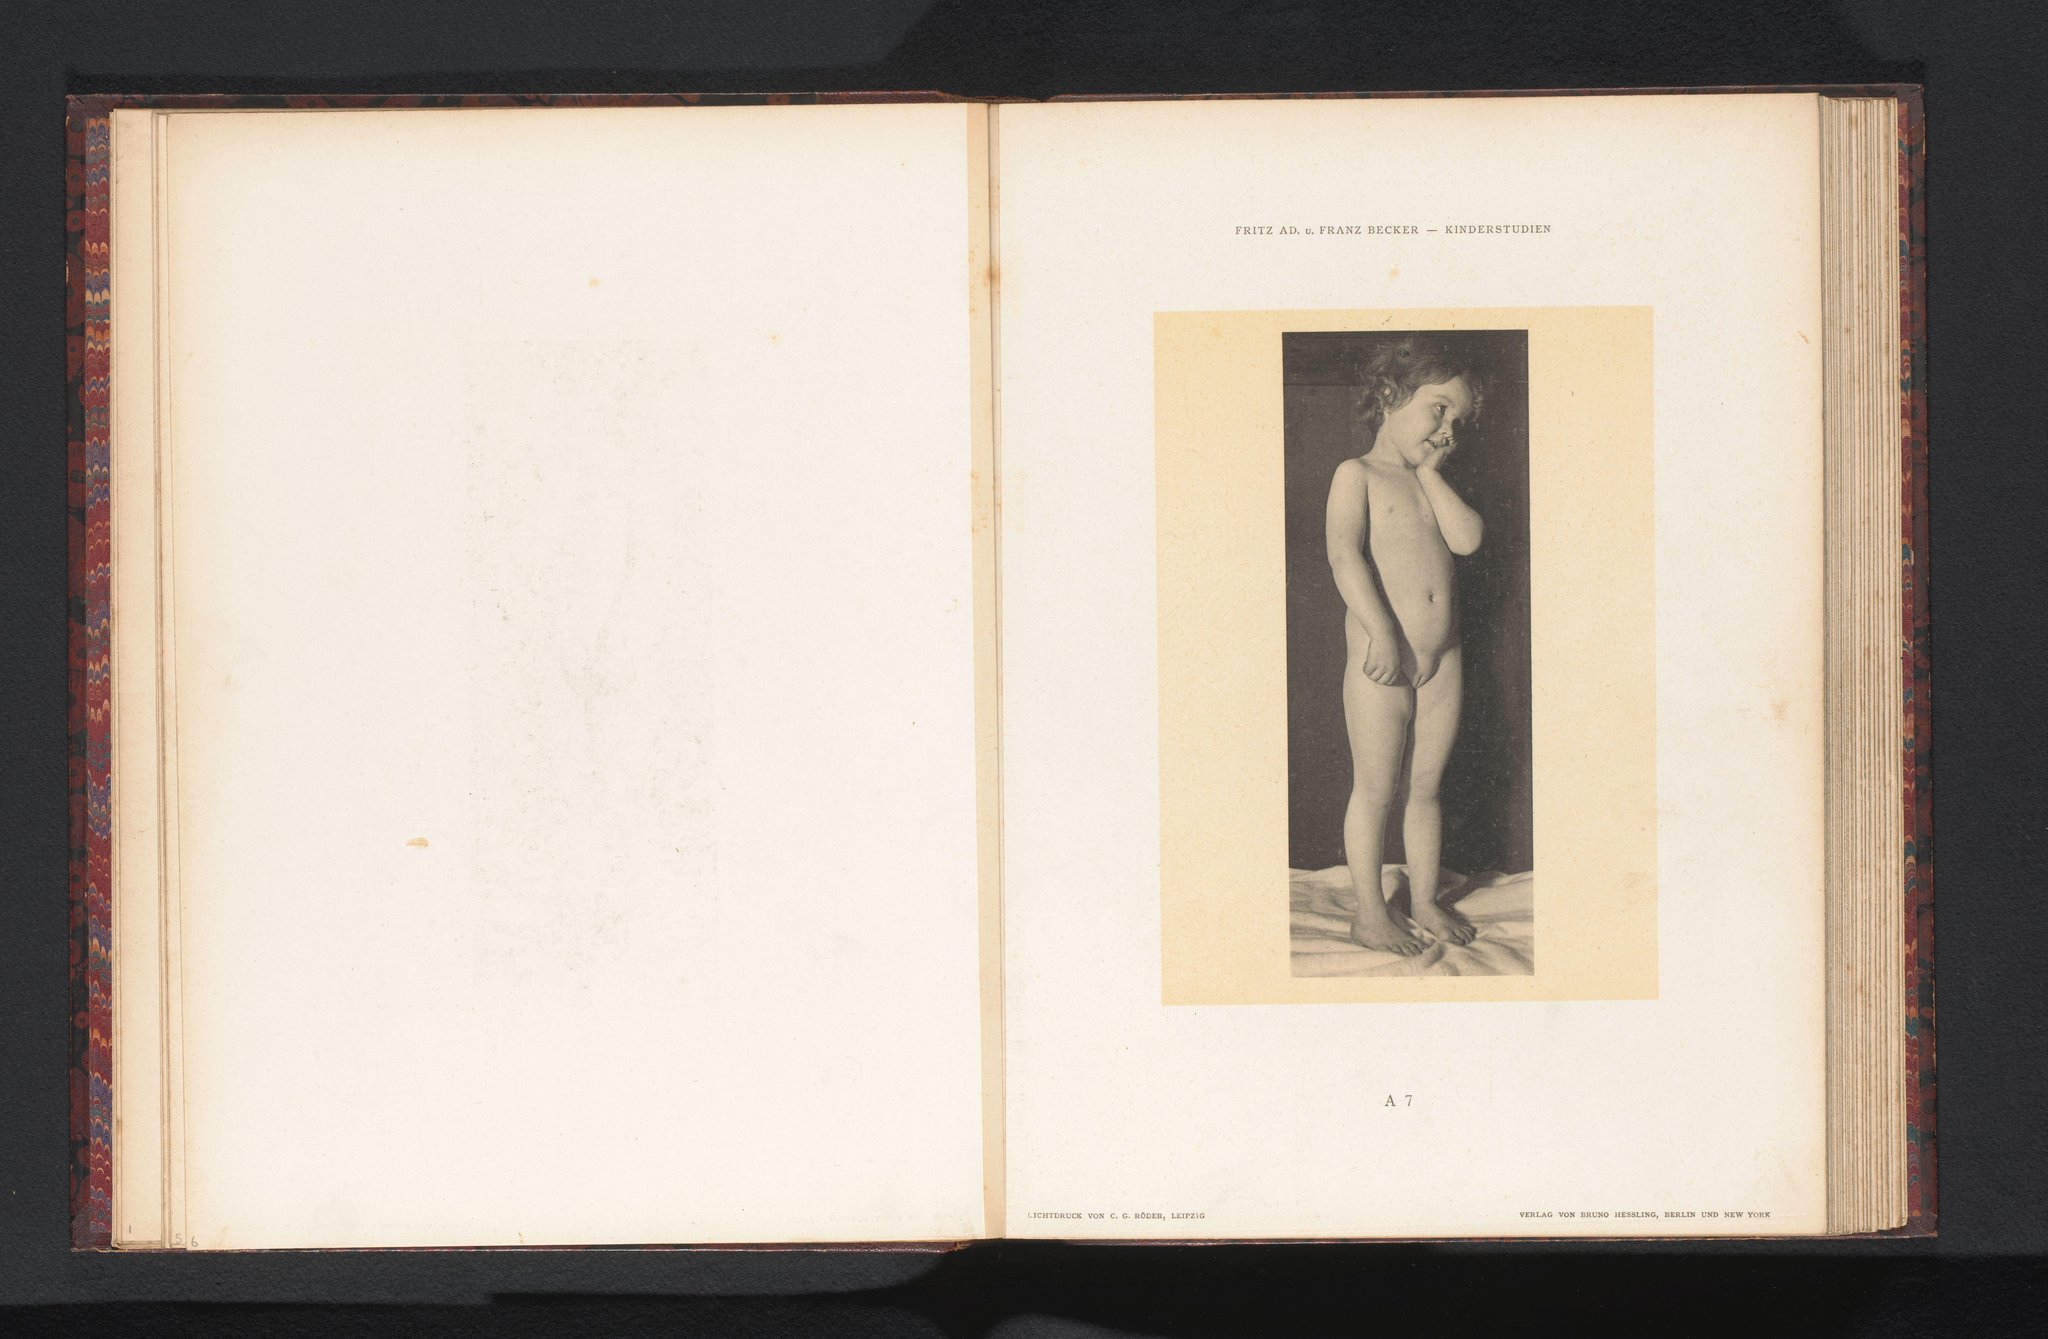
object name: page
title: Staand naakt meisje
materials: paper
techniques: photograph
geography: new york city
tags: toddler (female), standing figure - aa - female human figure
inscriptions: number: ‘A 7’